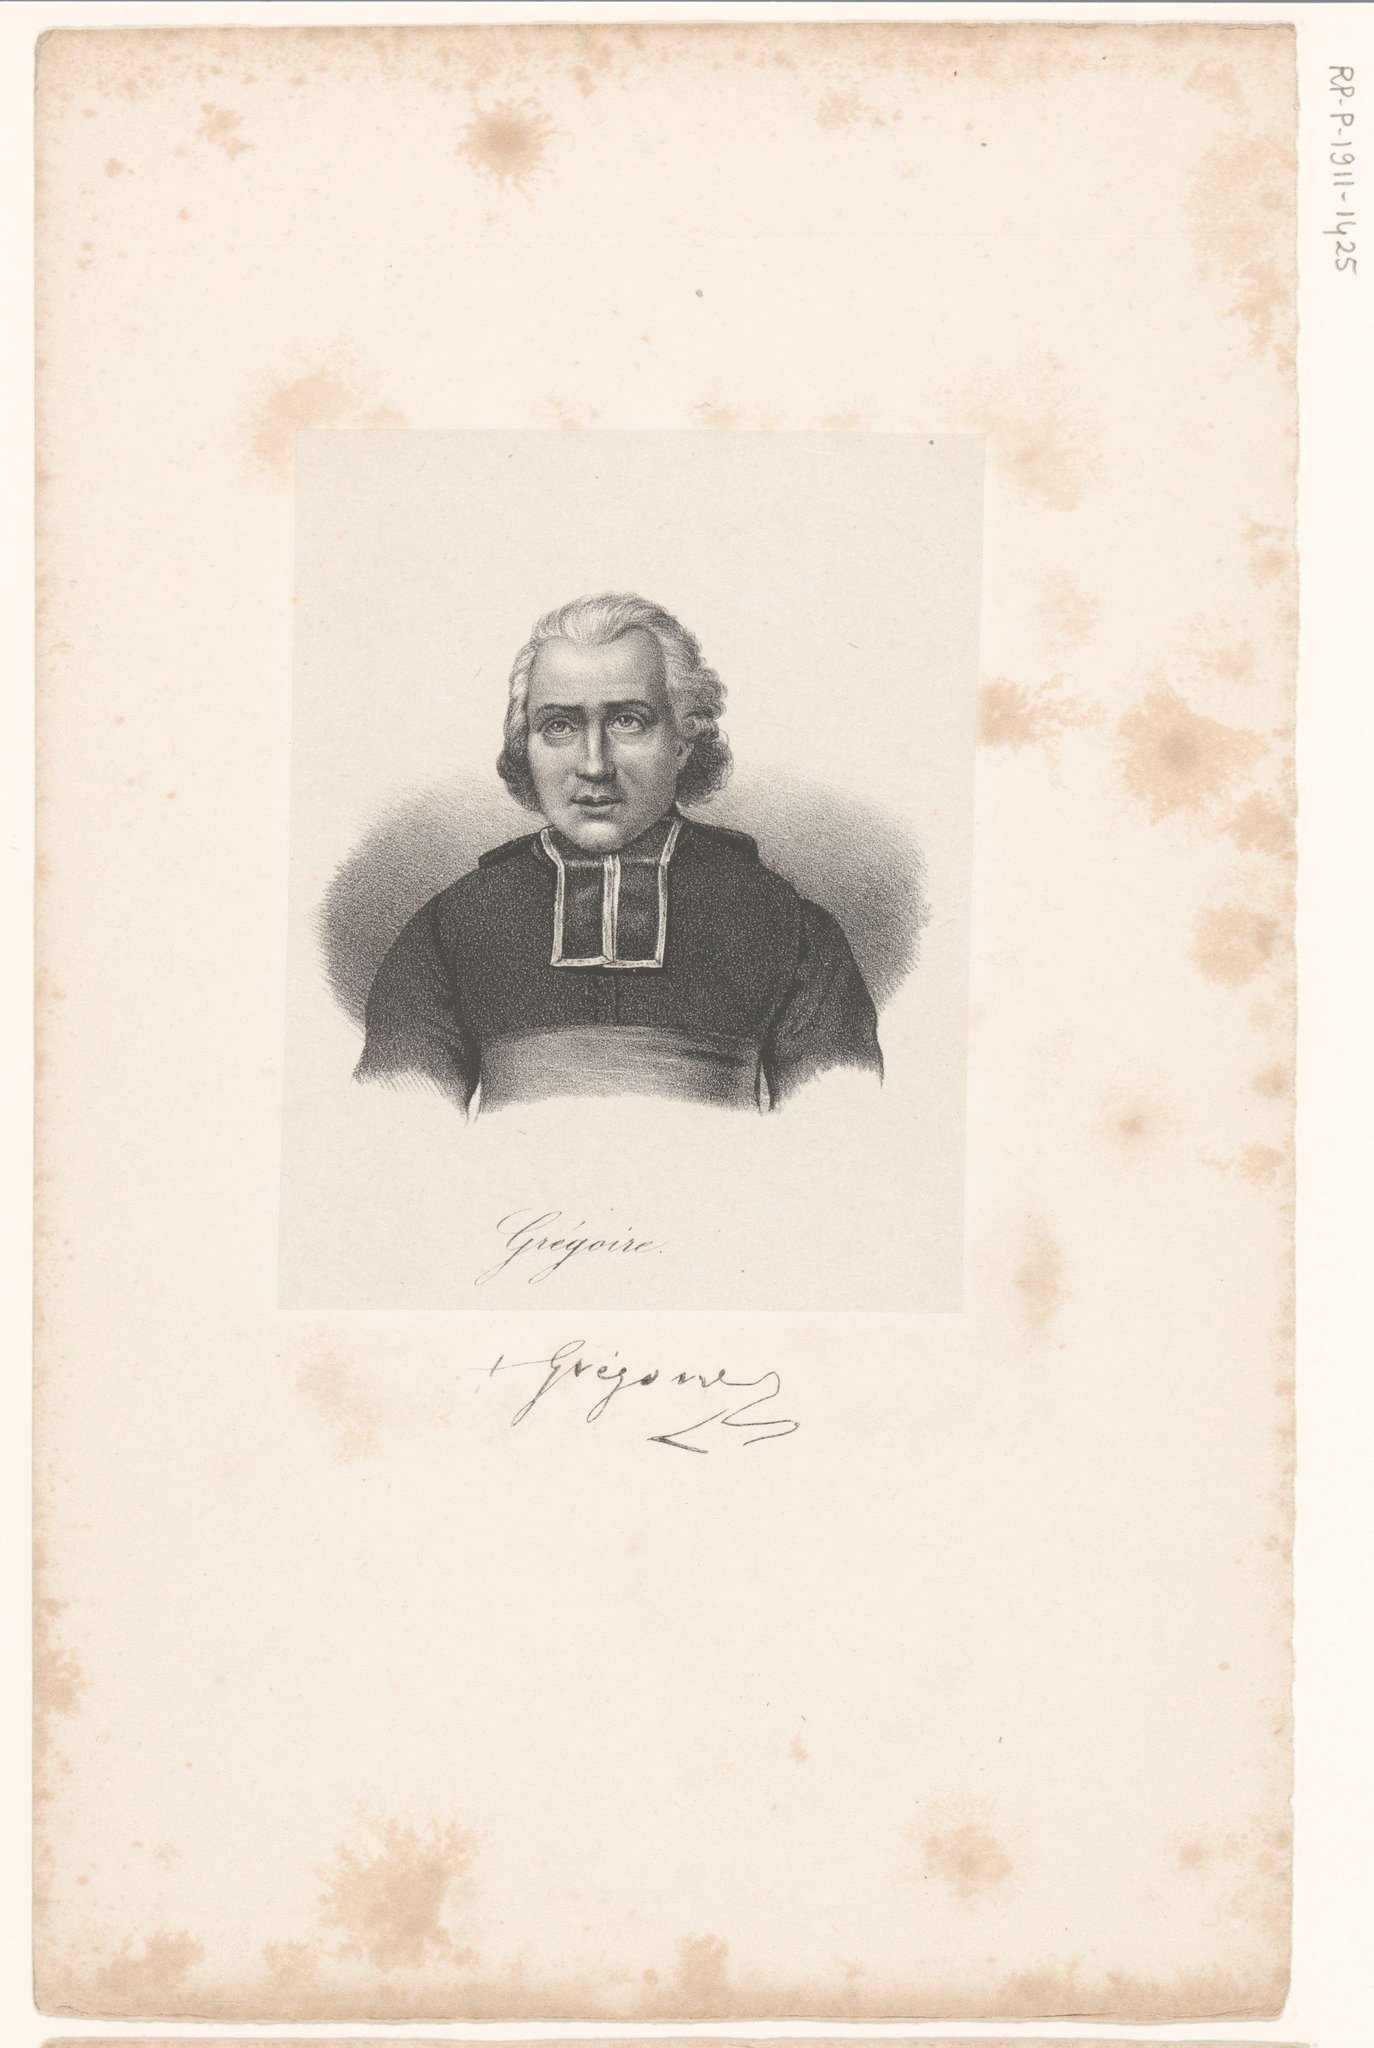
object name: print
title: Grégoire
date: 1831-1842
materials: paper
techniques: lithograph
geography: paris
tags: priest, historical persons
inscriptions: collector's mark: Lugt 2228a